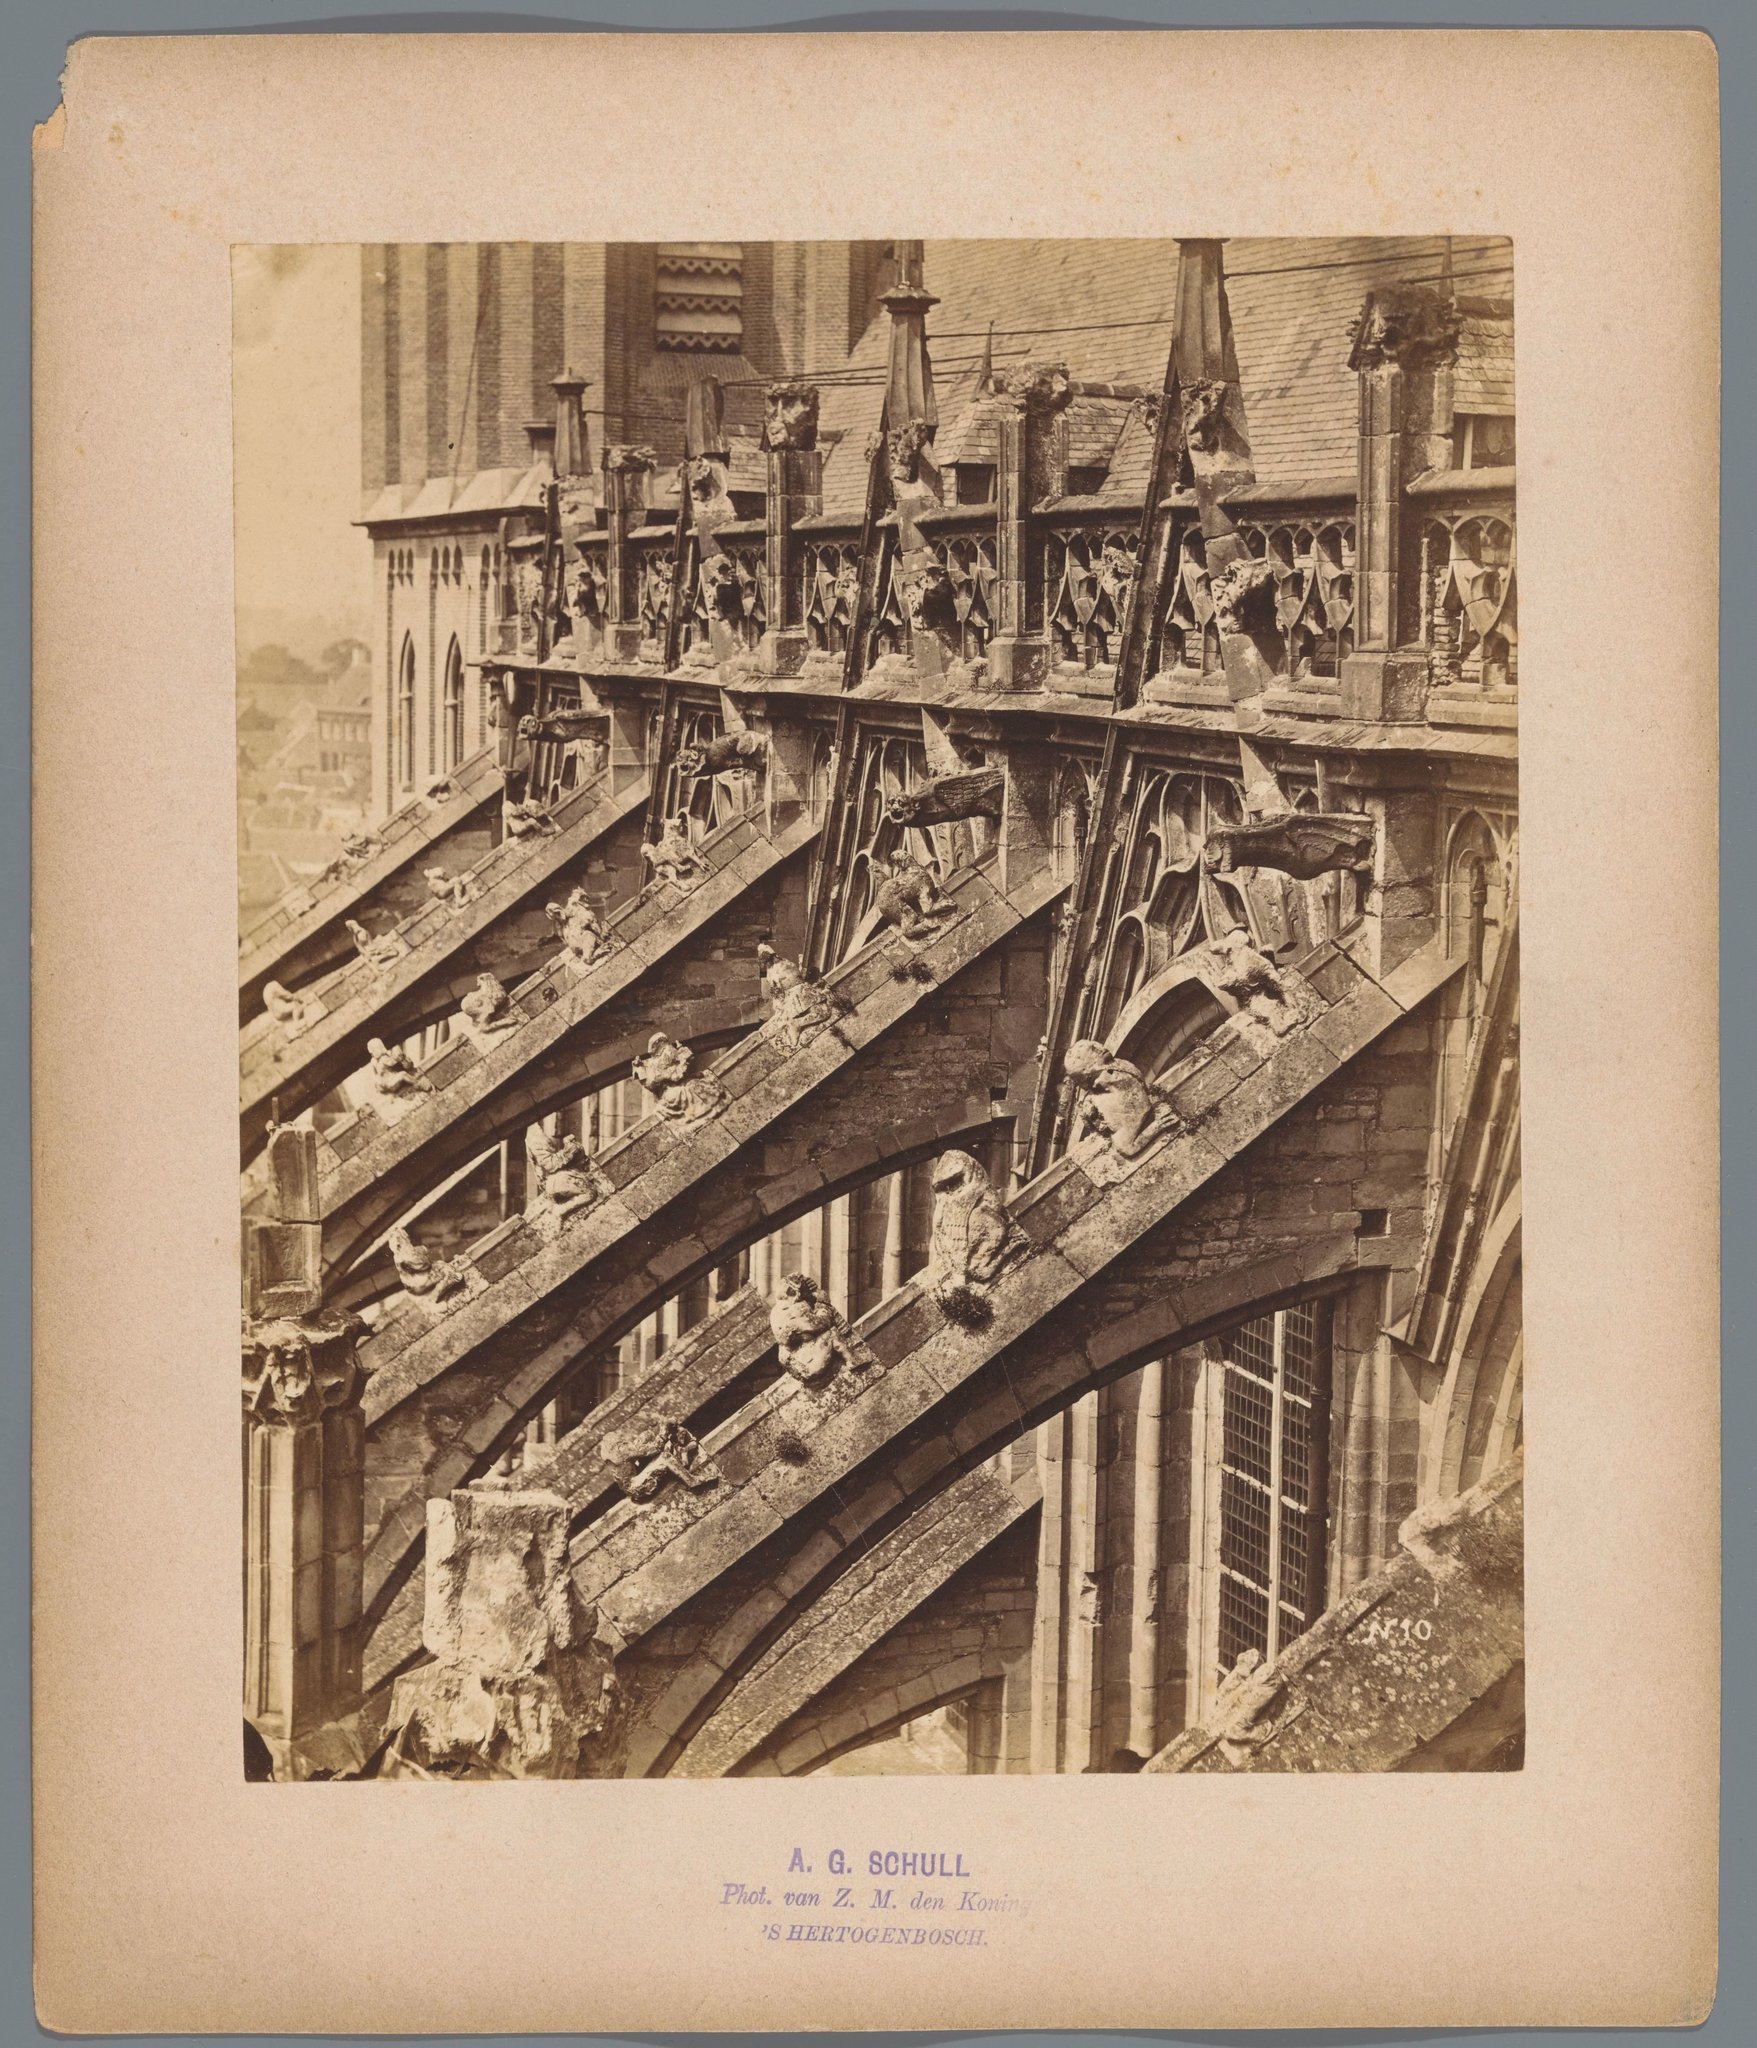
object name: photograph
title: Luchtboogfiguren op de Sint-Janskathedraal te 's-Hertogenbosch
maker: antonius godefridus schull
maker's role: fotograaf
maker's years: 1819-1896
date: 1875-1900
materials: cardboard, photographic support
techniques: albumen print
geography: den bosch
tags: church (exterior), sculpture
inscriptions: number: ‘N10’, name: ‘S. FRANCO, b. i. den Haag.’, collector's mark: Lugt 3937, name: ‘A. G. SCHULL Phot. van Z. M. den Koning 'S HERTOGENBOSCH.’